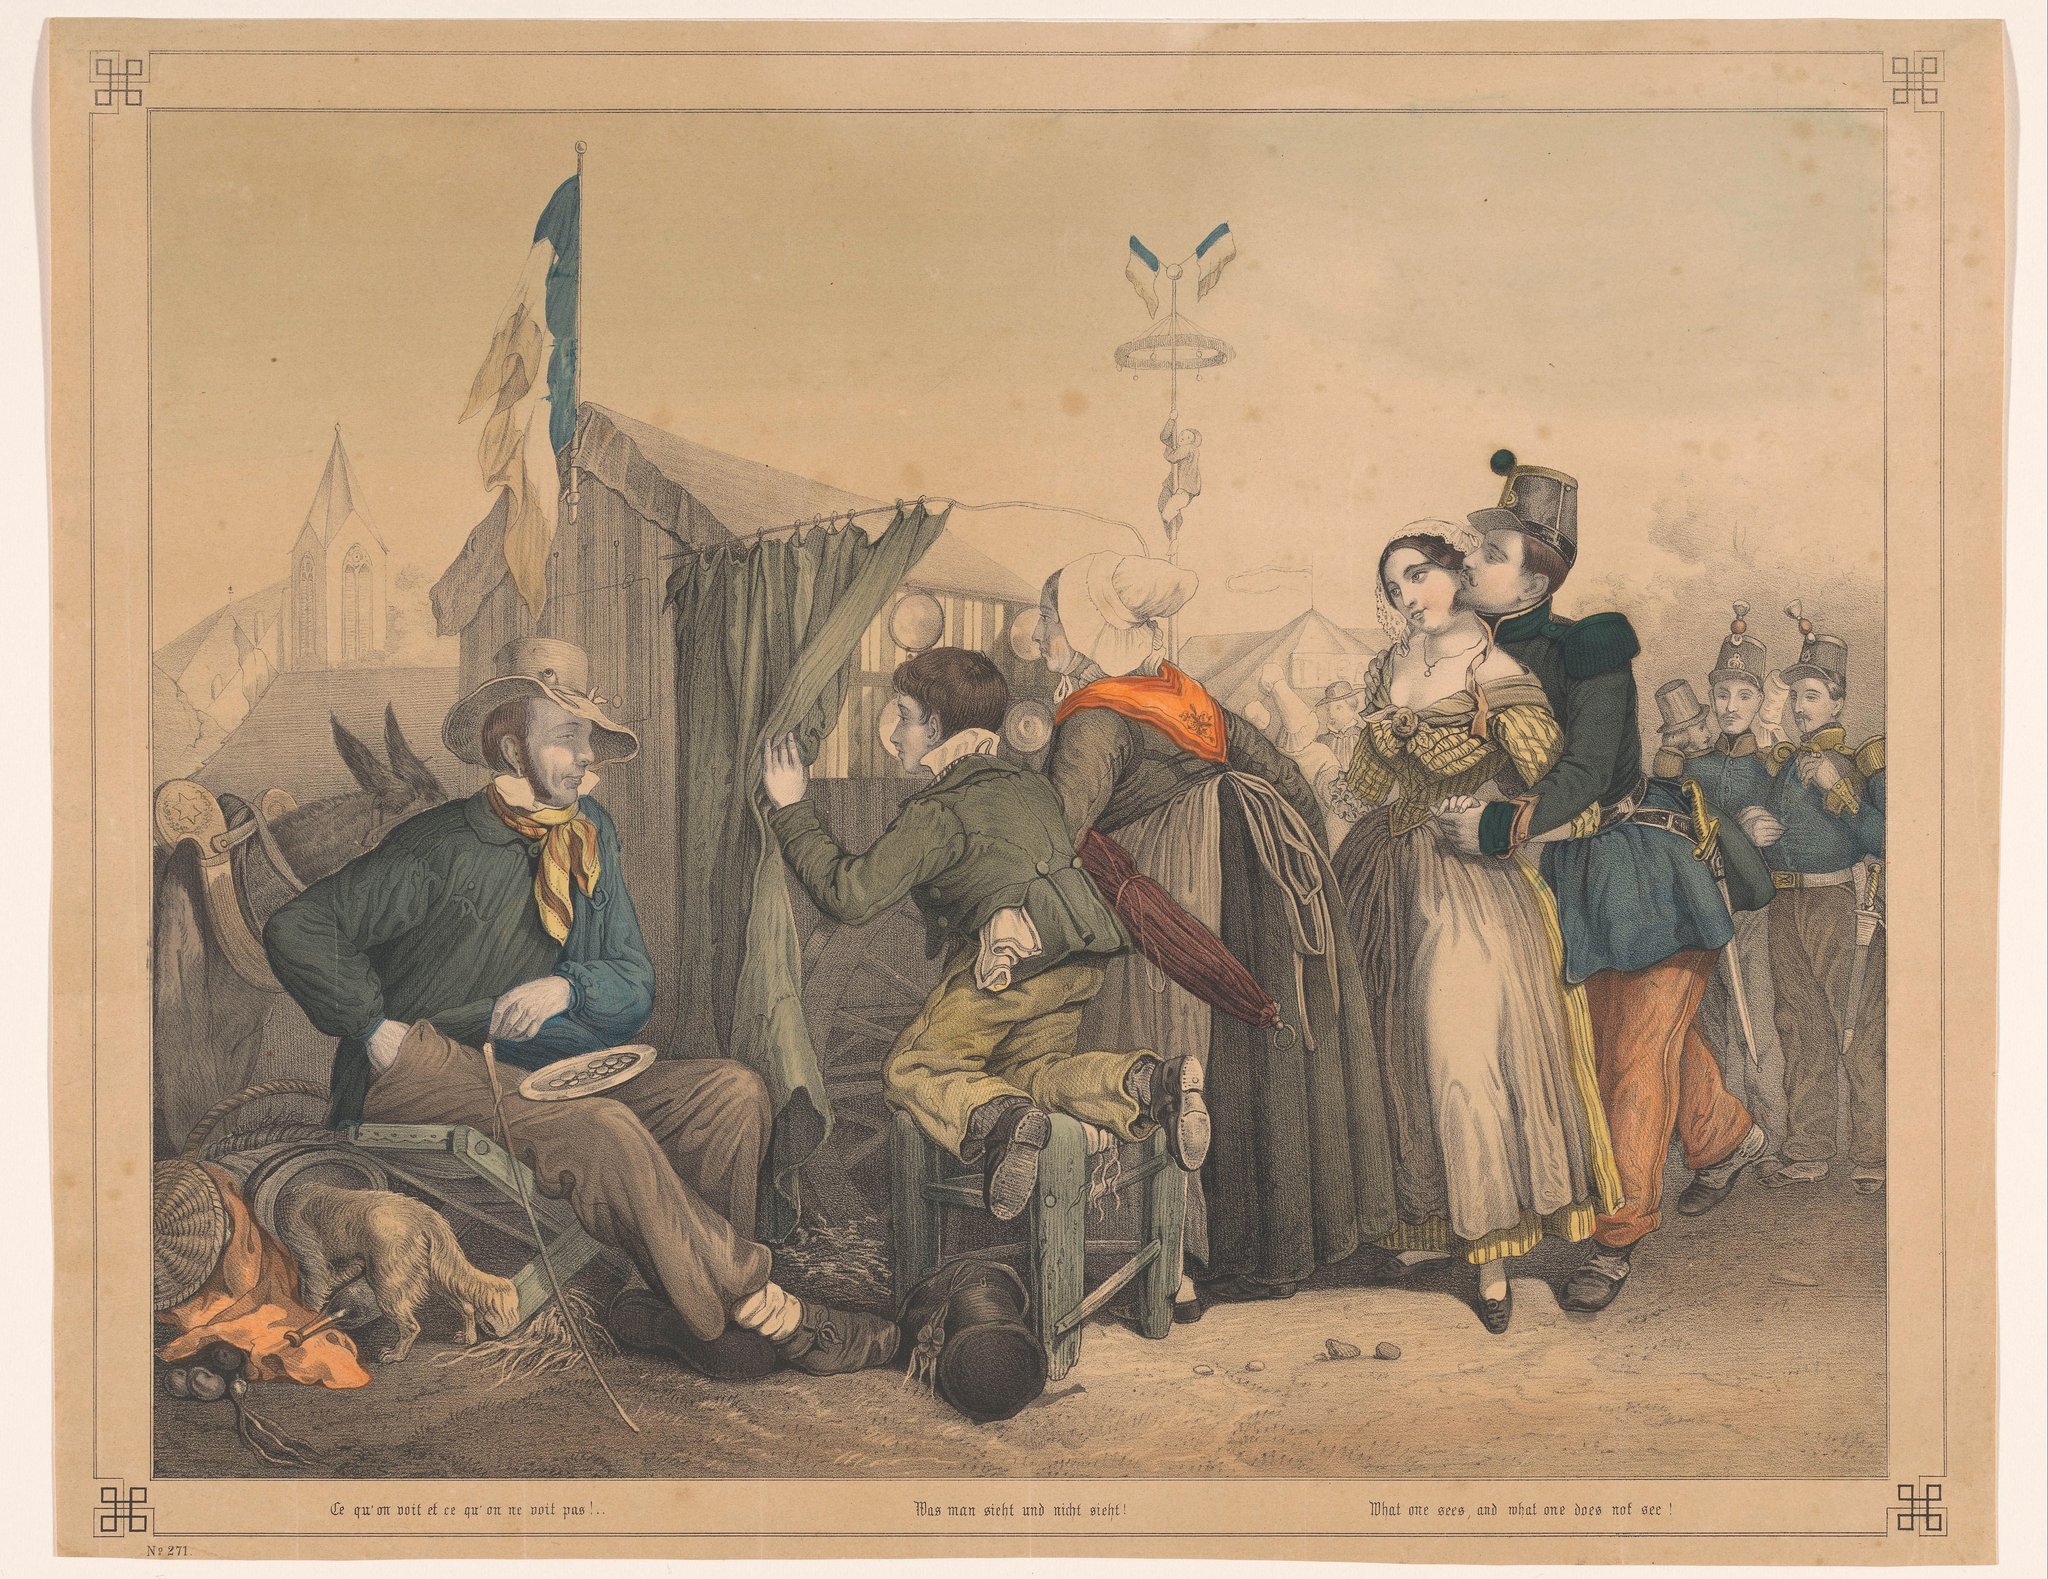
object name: print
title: Ce qu'on voit et ce qu'on ne voit pas! / Was man sieht und nicht sieht! / What one sees, and what one does not see!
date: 1825-1875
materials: paper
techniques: lithograph, drawing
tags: private soldier, pleasure fair and circus, peep-show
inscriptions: collector's mark: Lugt 2228, collector's mark: Lugt 4779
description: Een jongen en een vrouw kijken door een van de vensters van een kijkkast. Naast de kast zit de eigenaar met een bord met munten op zijn schoot. Naast hem een hond en een ezel. Rechts staan drie soldaten; een van hen omhelst een jonge vrouw. In de achtergrond klimt een jongen omhoog langs een paal. De paal en de kijkkast zijn versierd met Franse vlaggen. Linksonder genummerd: No. 271.